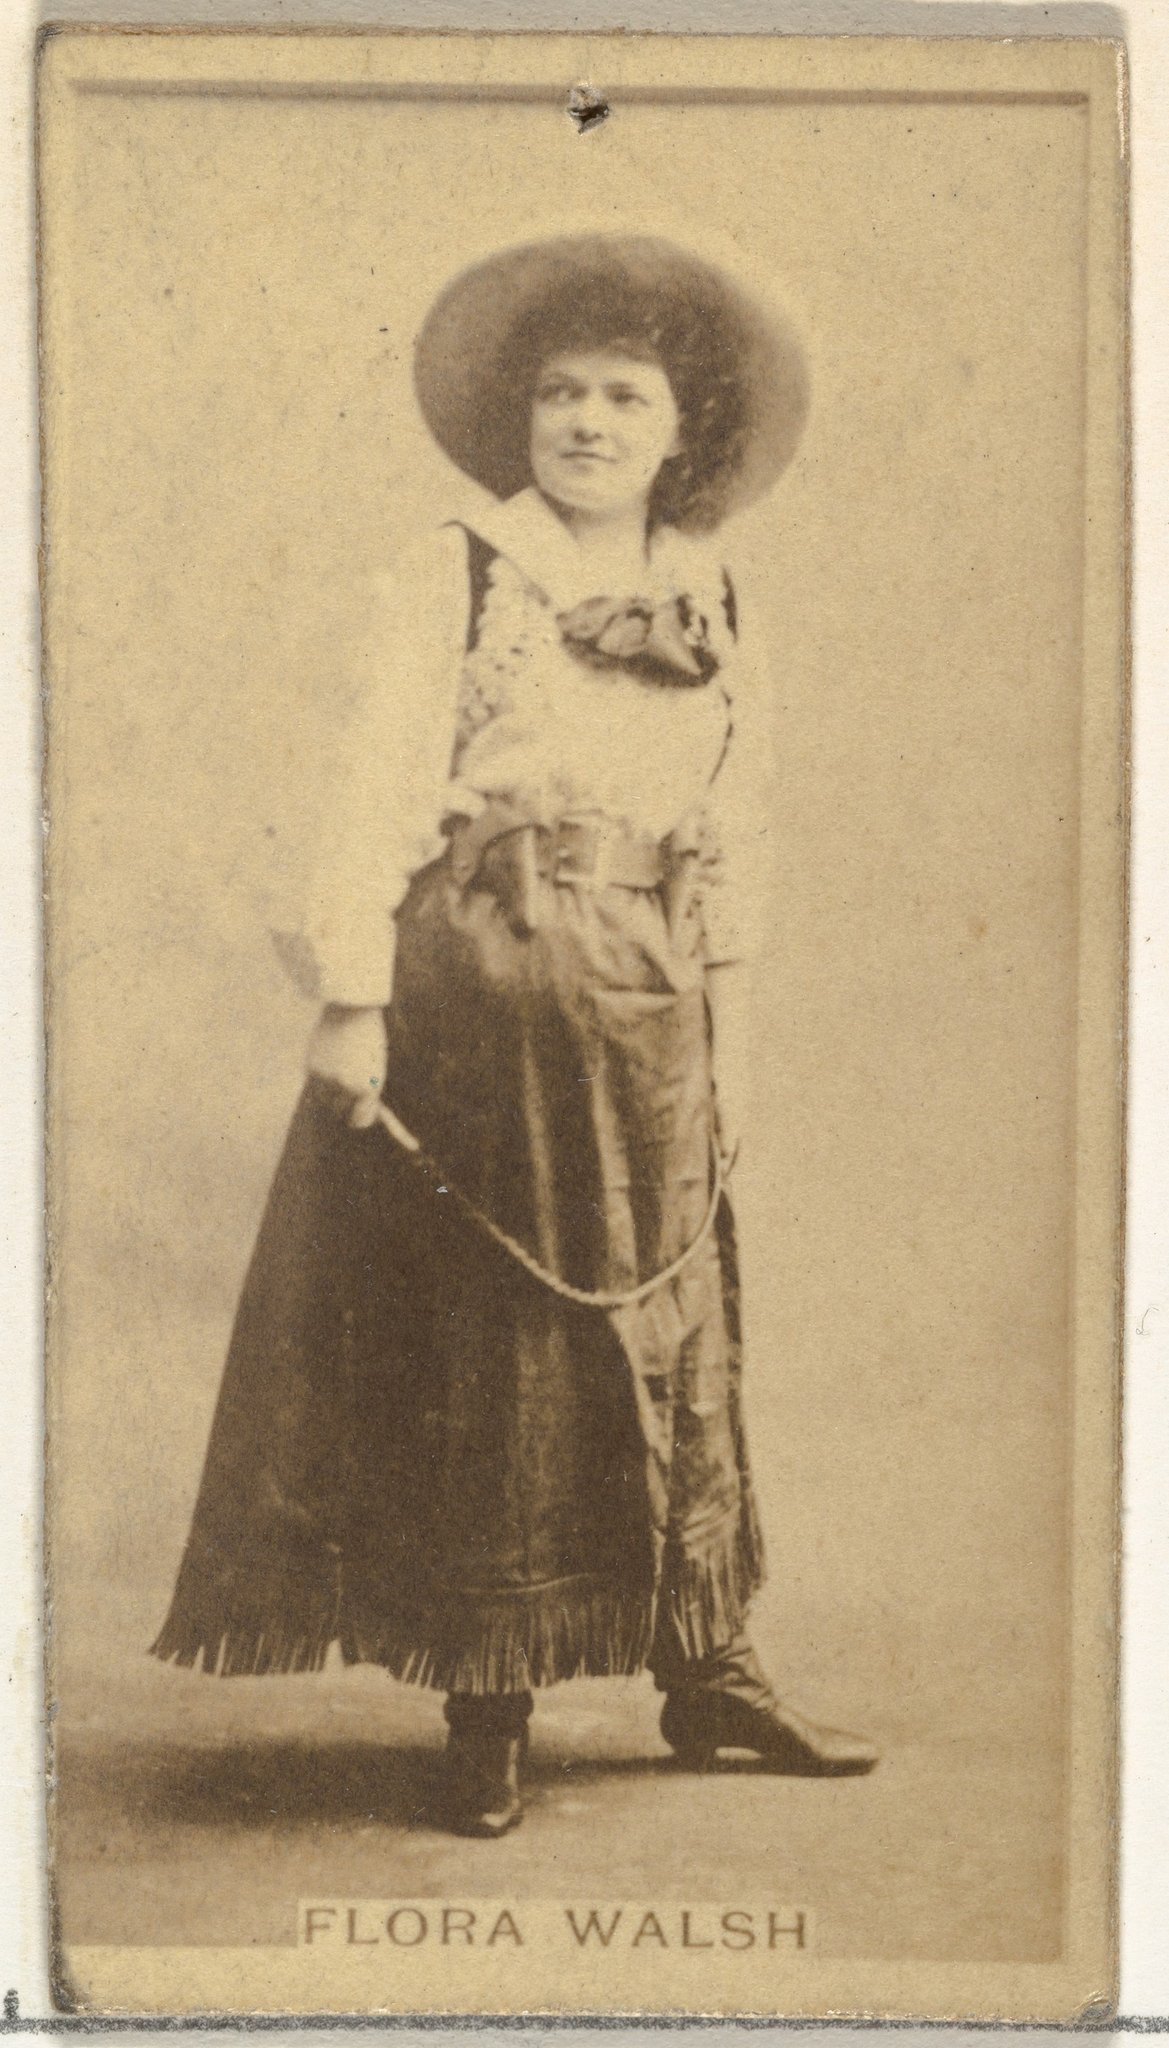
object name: photograph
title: Flora Walsh, from the Actors and Actresses series (N145-8) issued by Duke Sons & Co. to promote Duke Cigarettes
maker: w. duke, sons & co.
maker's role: publisher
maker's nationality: american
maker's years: 1870-1920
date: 1891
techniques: albumen silver print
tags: portraits,women,actresses